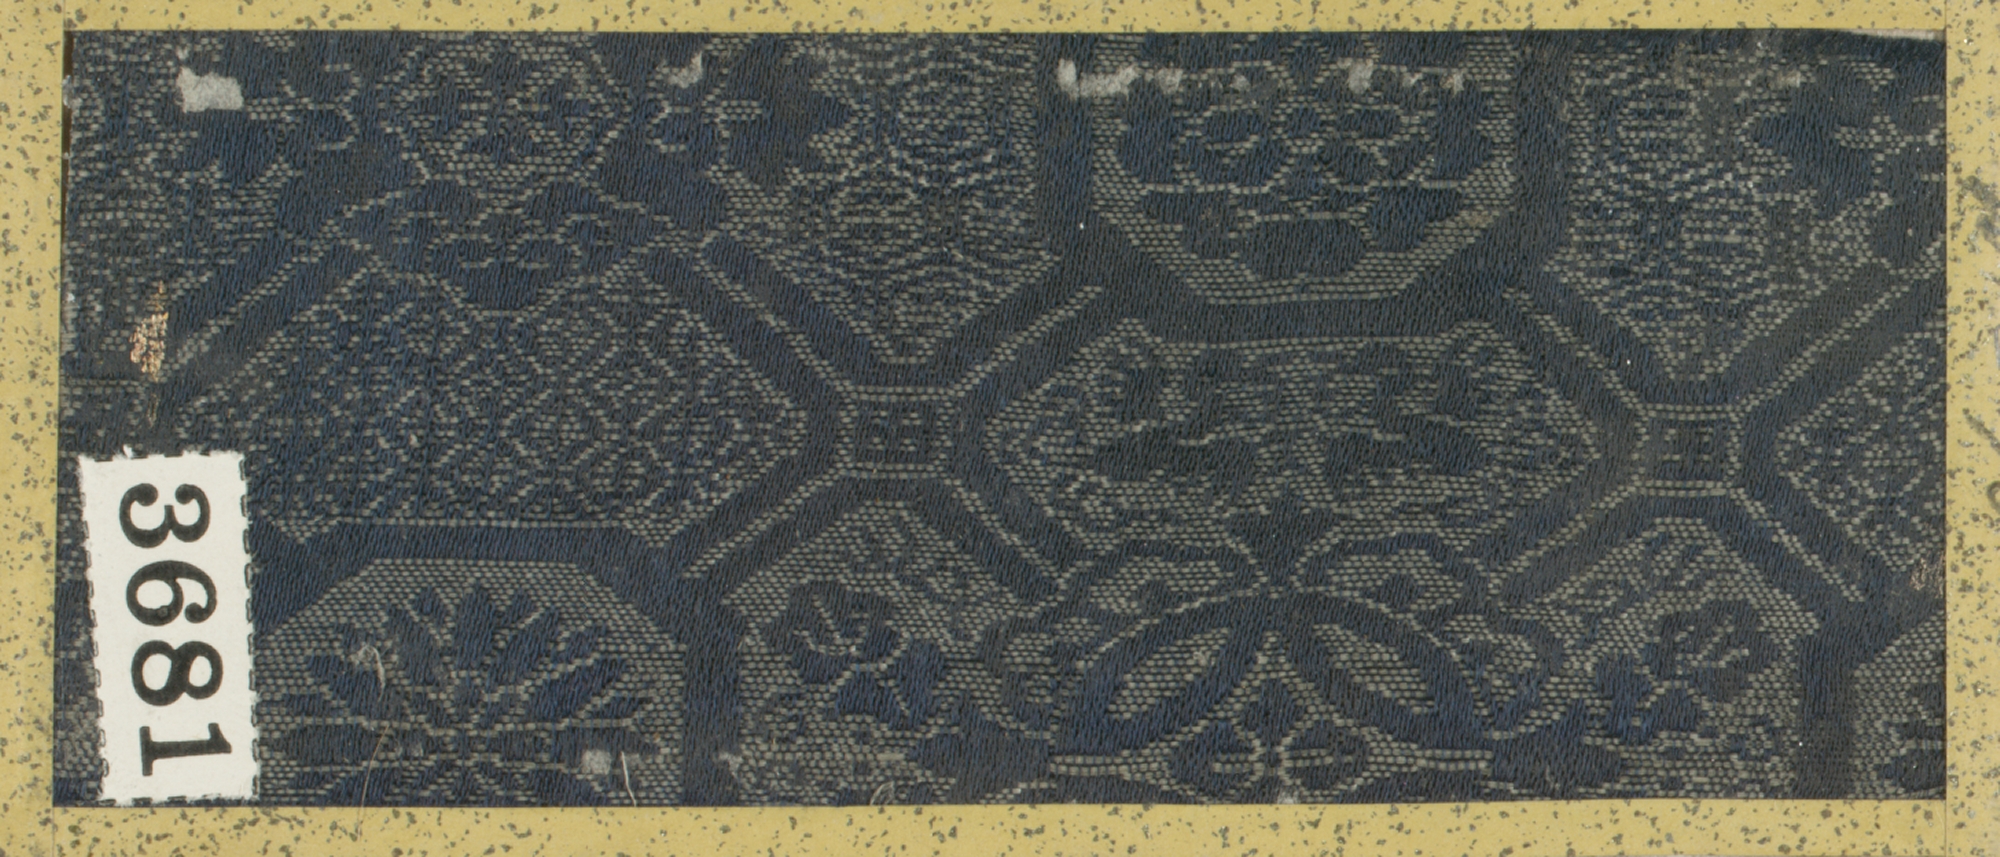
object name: sample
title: Textile Sample from Sample Book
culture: japanese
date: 1801-1900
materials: silk